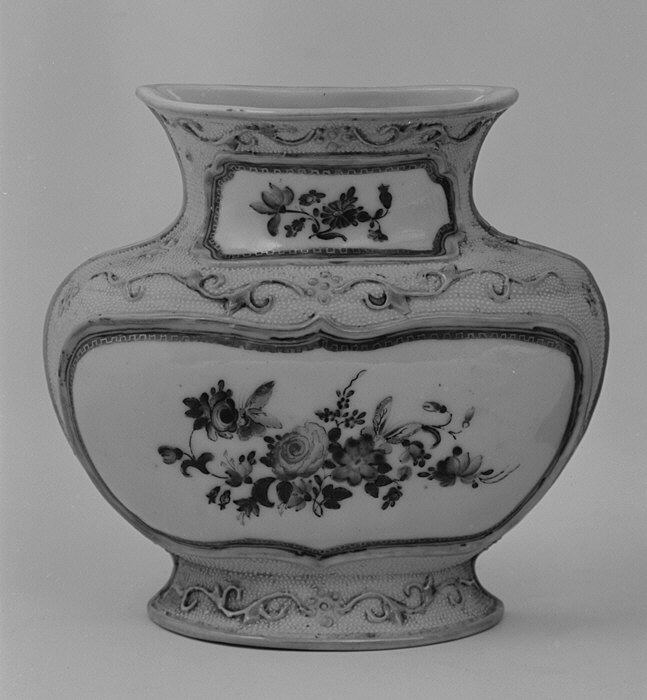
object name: wall vase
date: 1740-1770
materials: hard paste porcelain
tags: flowers